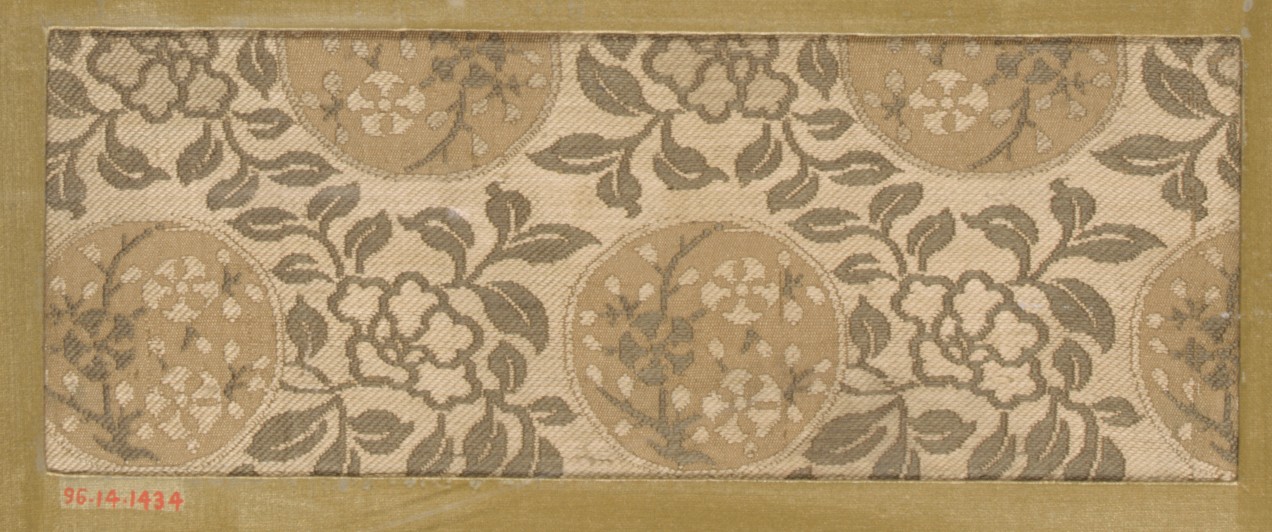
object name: piece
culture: japanese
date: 1701-1900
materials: silk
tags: flowers